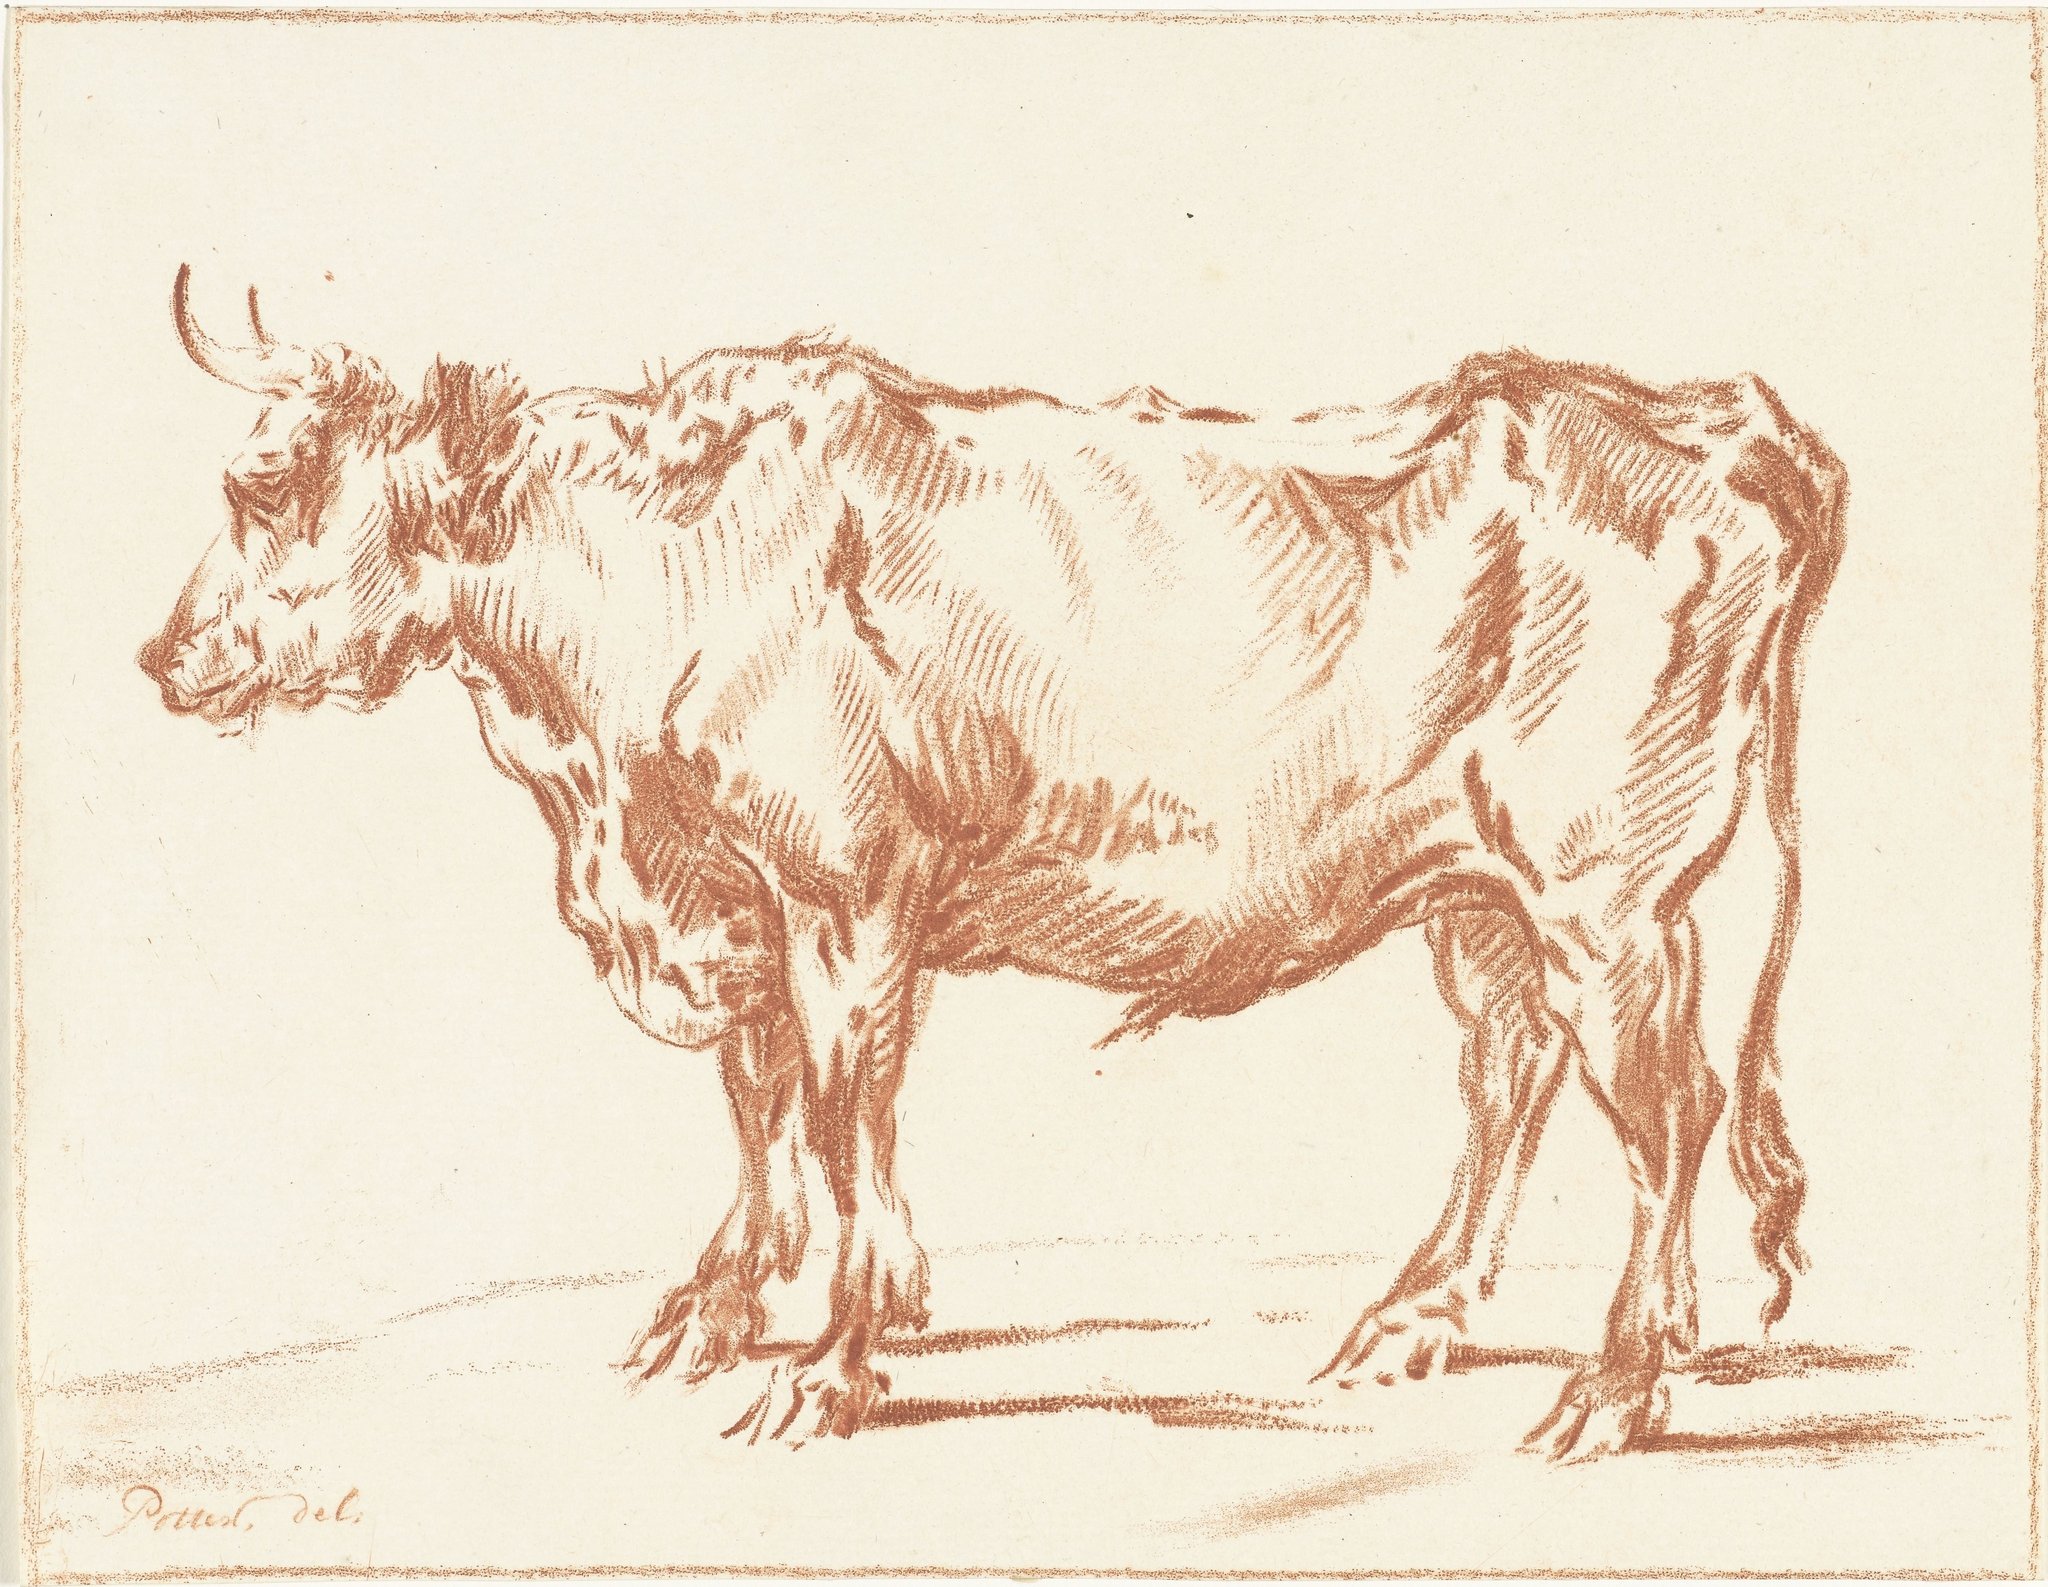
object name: print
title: Staande os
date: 1724-1798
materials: paper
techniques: printmaking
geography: amsterdam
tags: ox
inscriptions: collector's mark: Lugt 2228